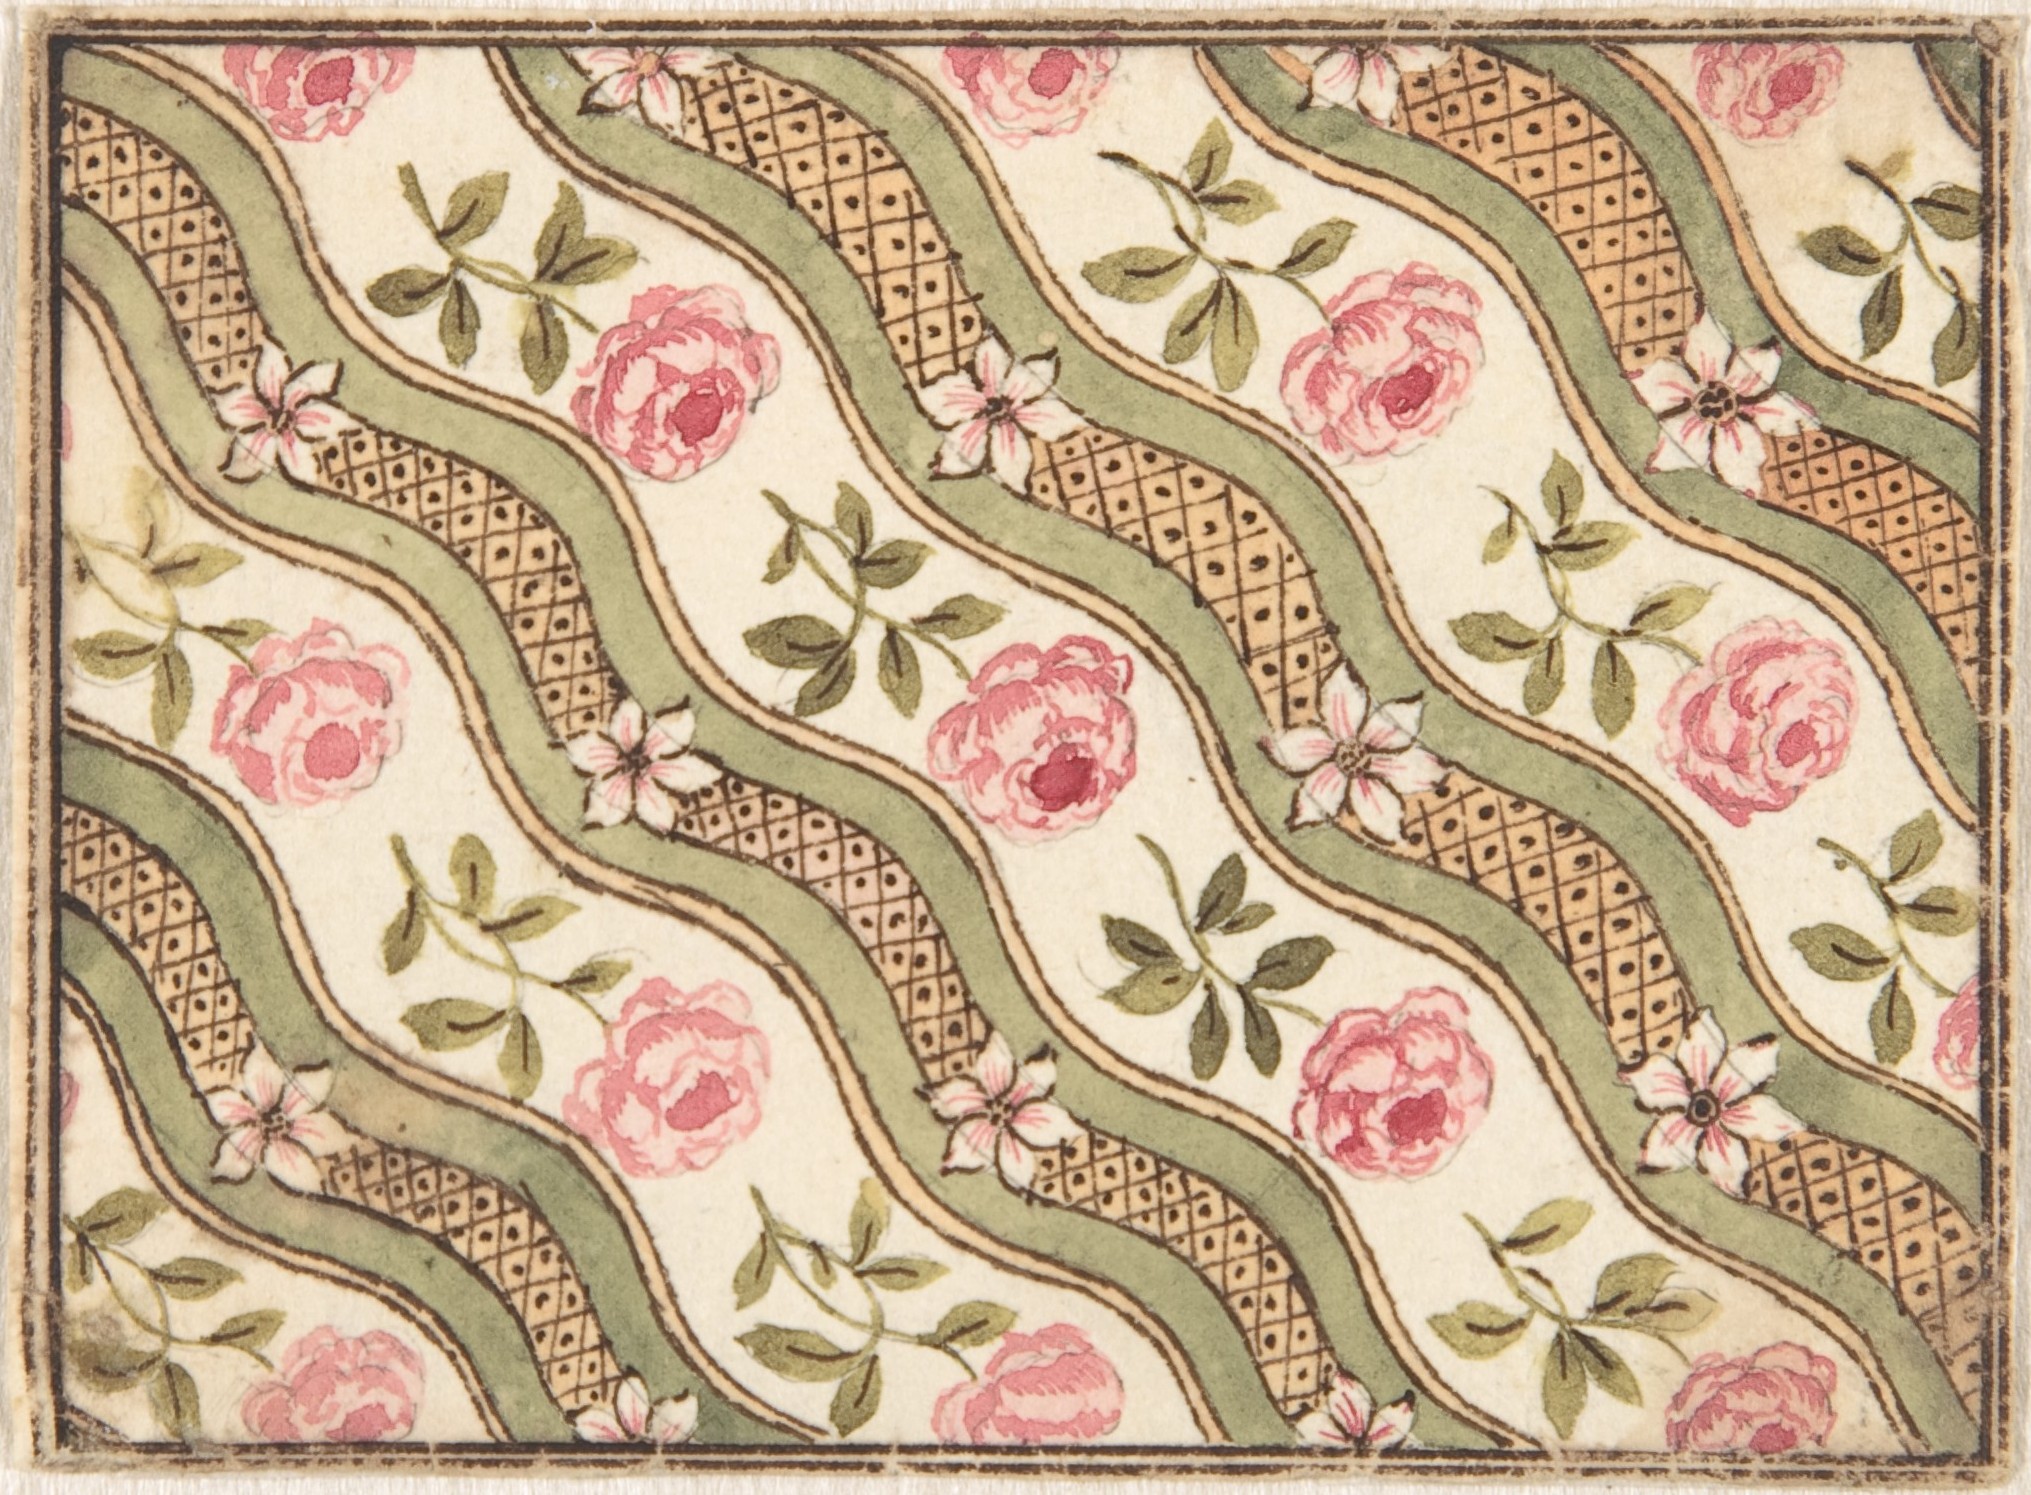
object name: drawing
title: Design for a Snuffbox Lid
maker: anonymous, french, 18th century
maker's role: artist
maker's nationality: french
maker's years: 1700-1800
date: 1750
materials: ink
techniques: brush, pen, wash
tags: roses